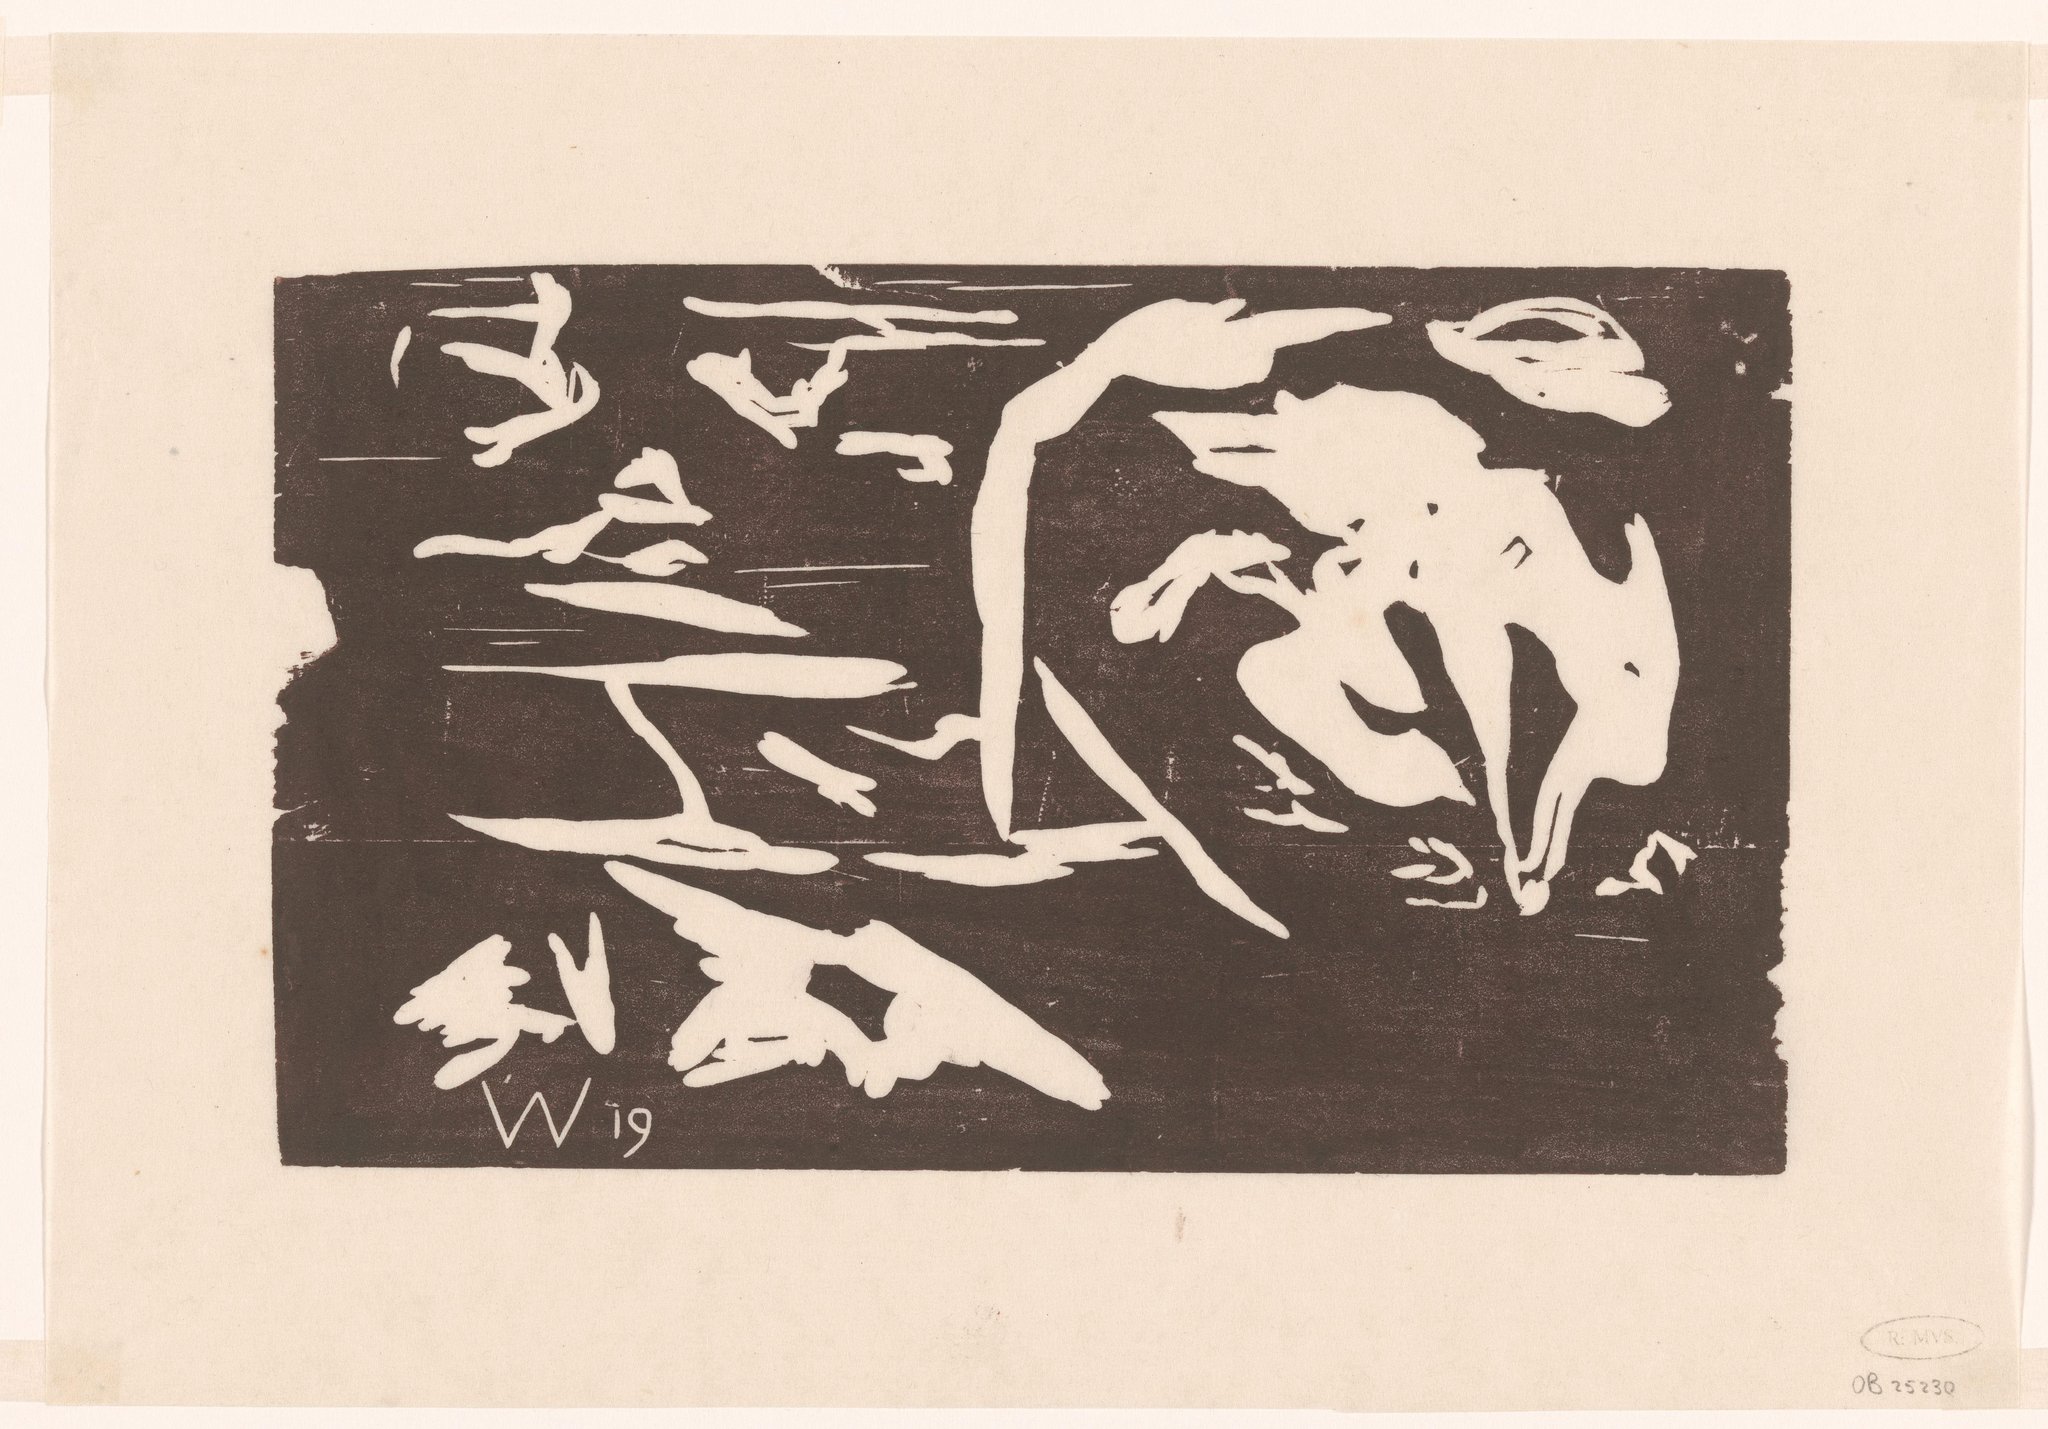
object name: print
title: Abstracte compositie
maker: erich wichmann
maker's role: print maker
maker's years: 1890-1929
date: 1919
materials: paper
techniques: woodcut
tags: abstract, non-representational art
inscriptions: collector's mark: Lugt 2228